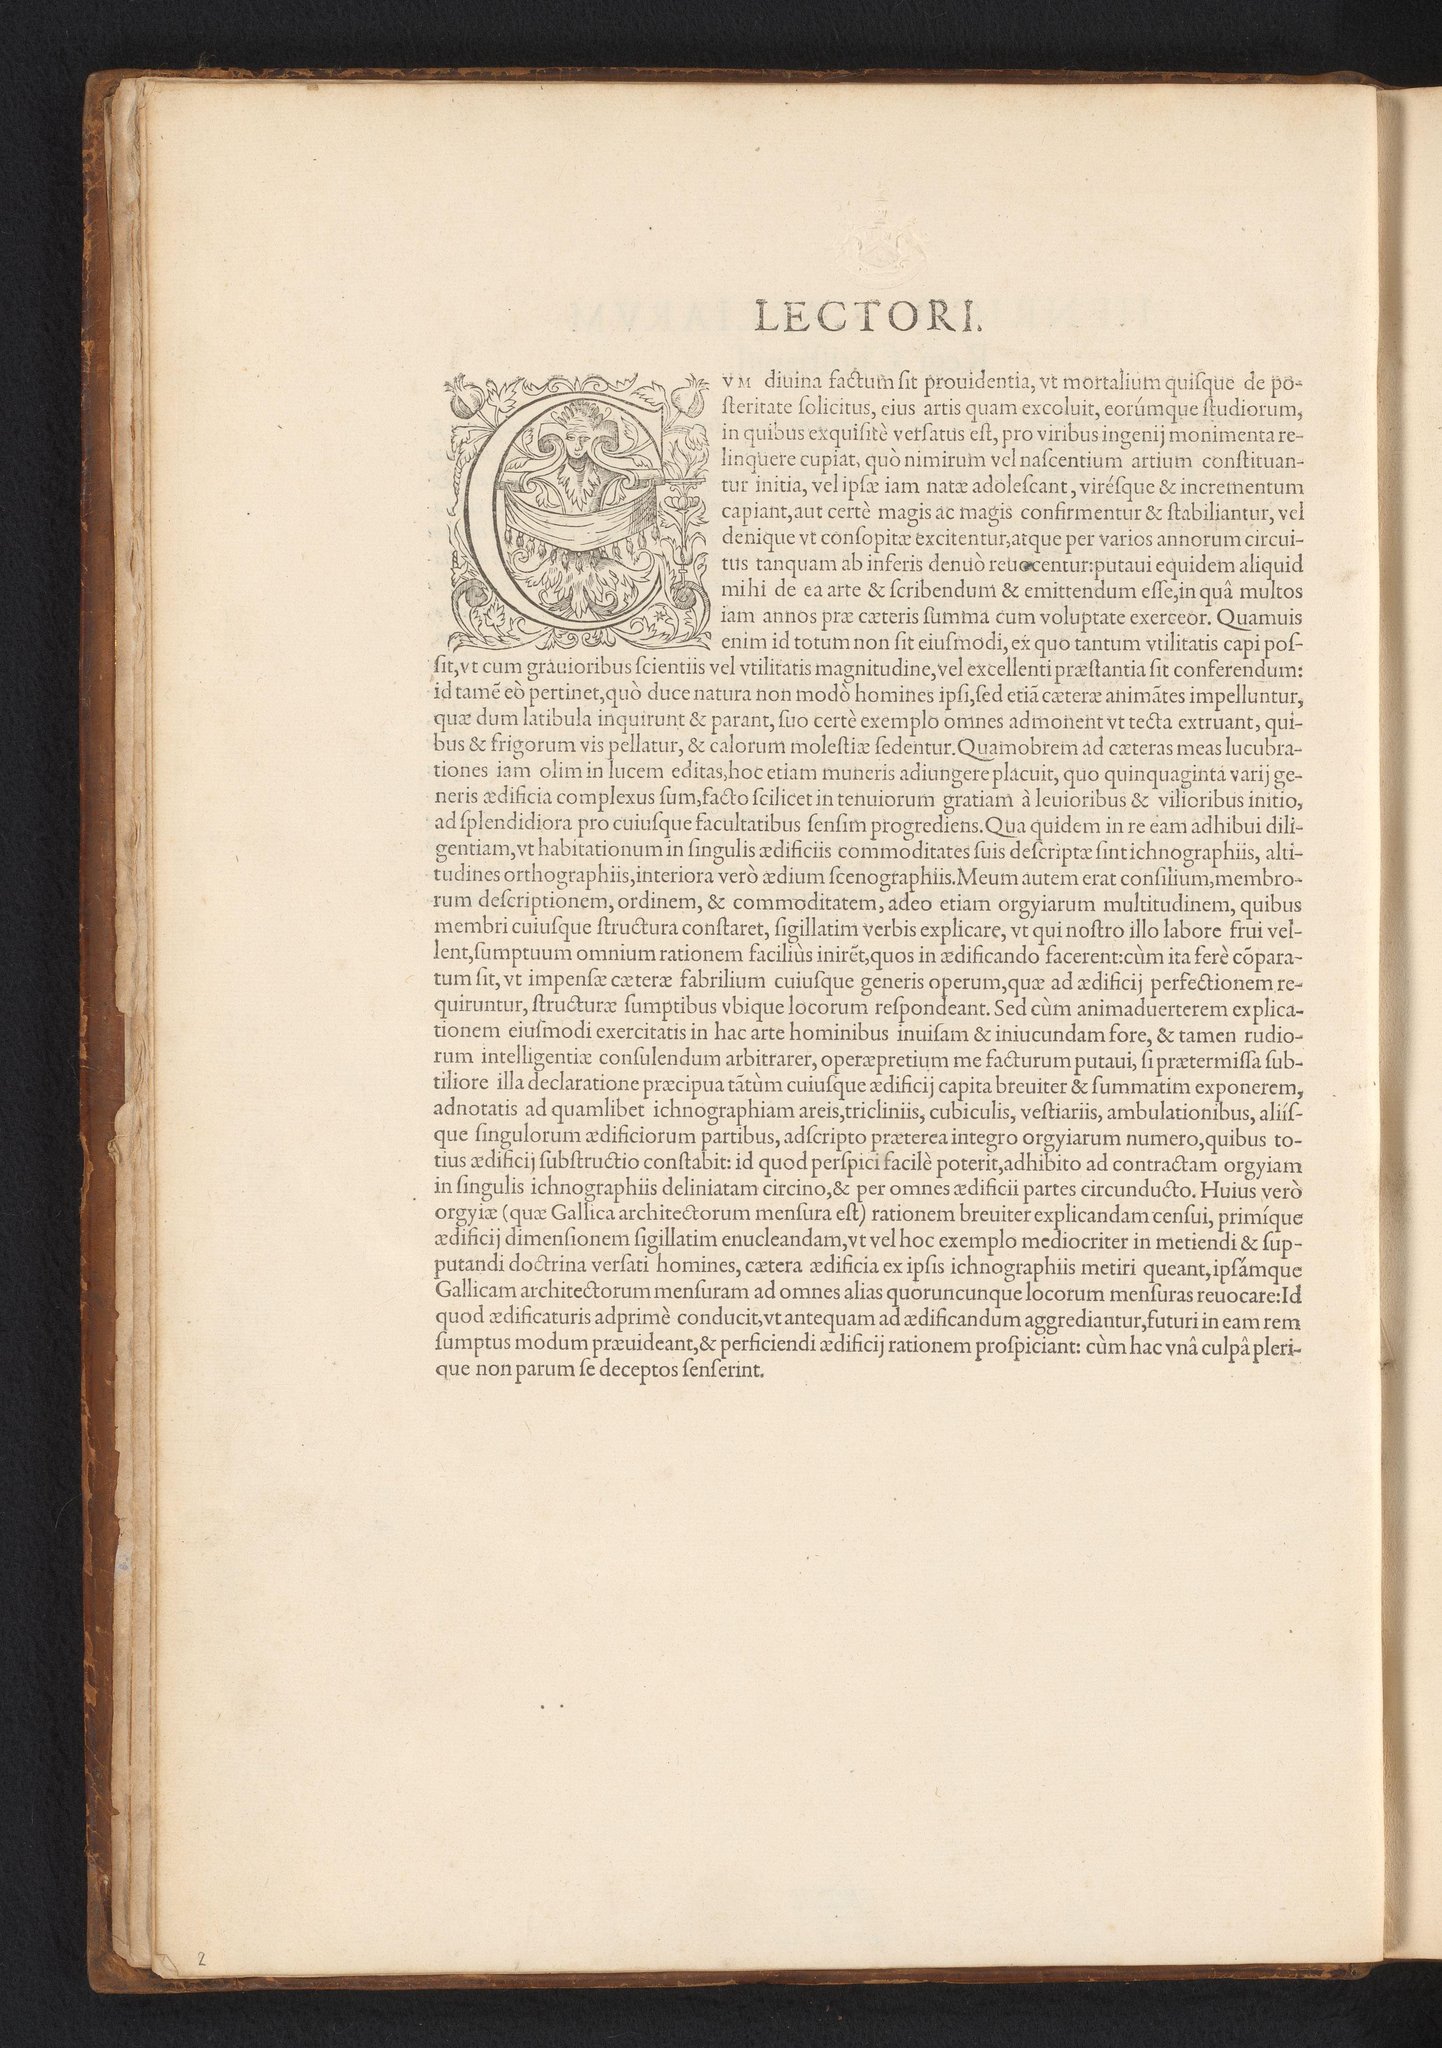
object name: text sheet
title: Aan de lezer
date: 1559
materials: paper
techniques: letterpress printing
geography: paris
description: Blad met gedrukte tekst 'aan de lezer'. Onderdeel van 'De architectura Iacobi Androuetii du Cerceau' (1559): 69 etsen met 171 voorstellingen van architectuur en ornamentiek.